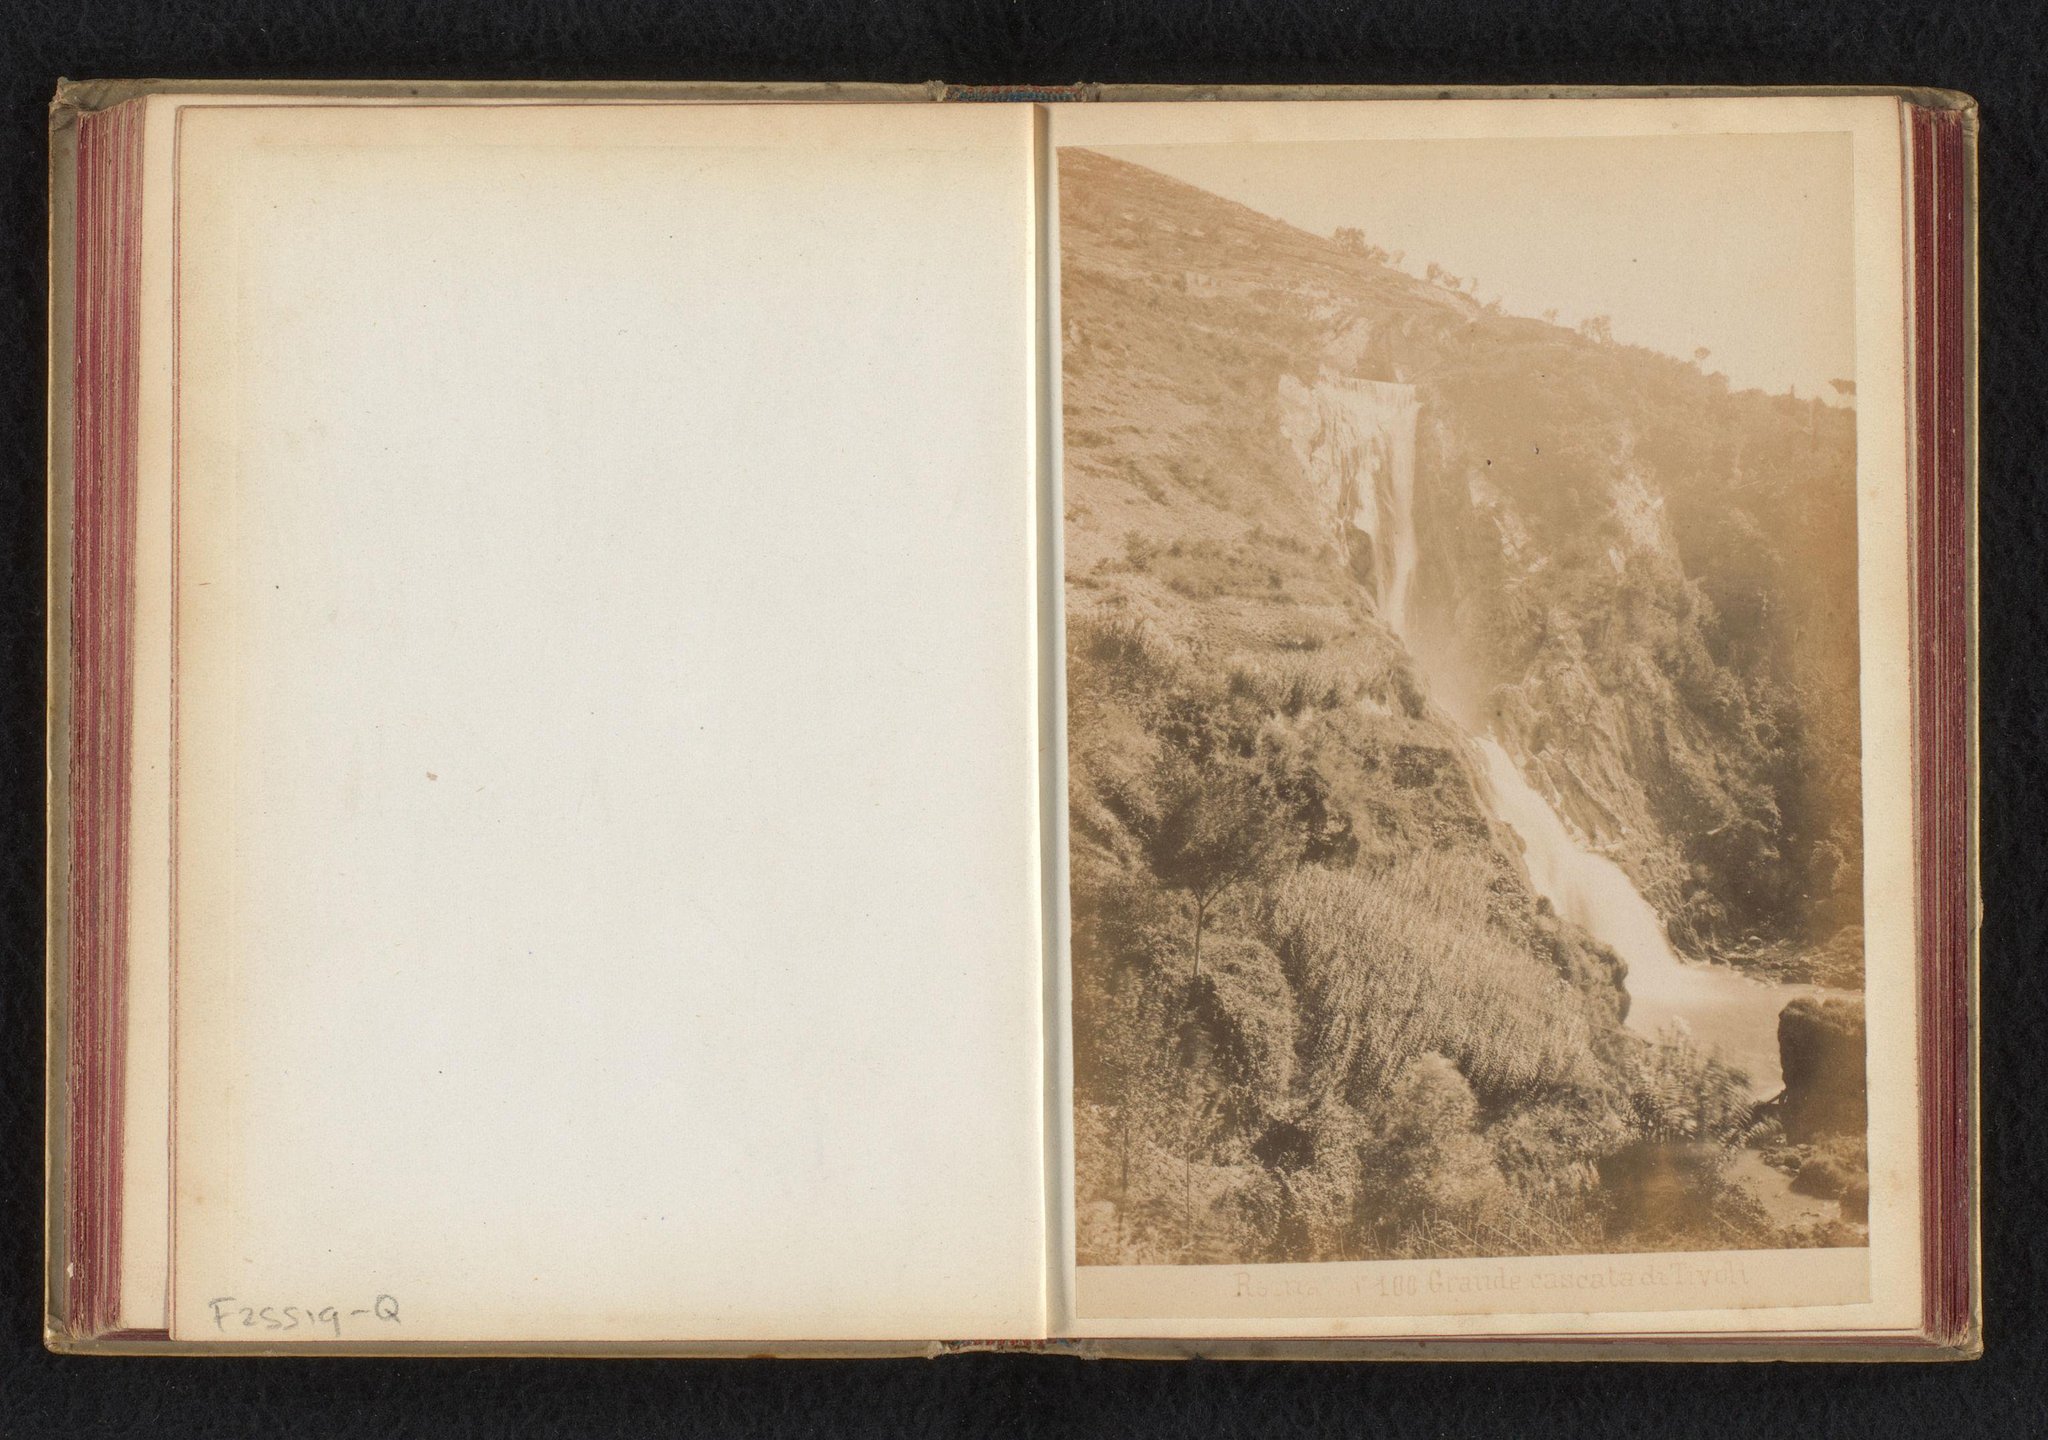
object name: photograph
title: Grote waterval bij Tivoli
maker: Anonymous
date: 1851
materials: paper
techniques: albumen print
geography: tivoli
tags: waterfall, tivoli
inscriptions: number: ‘No 100’